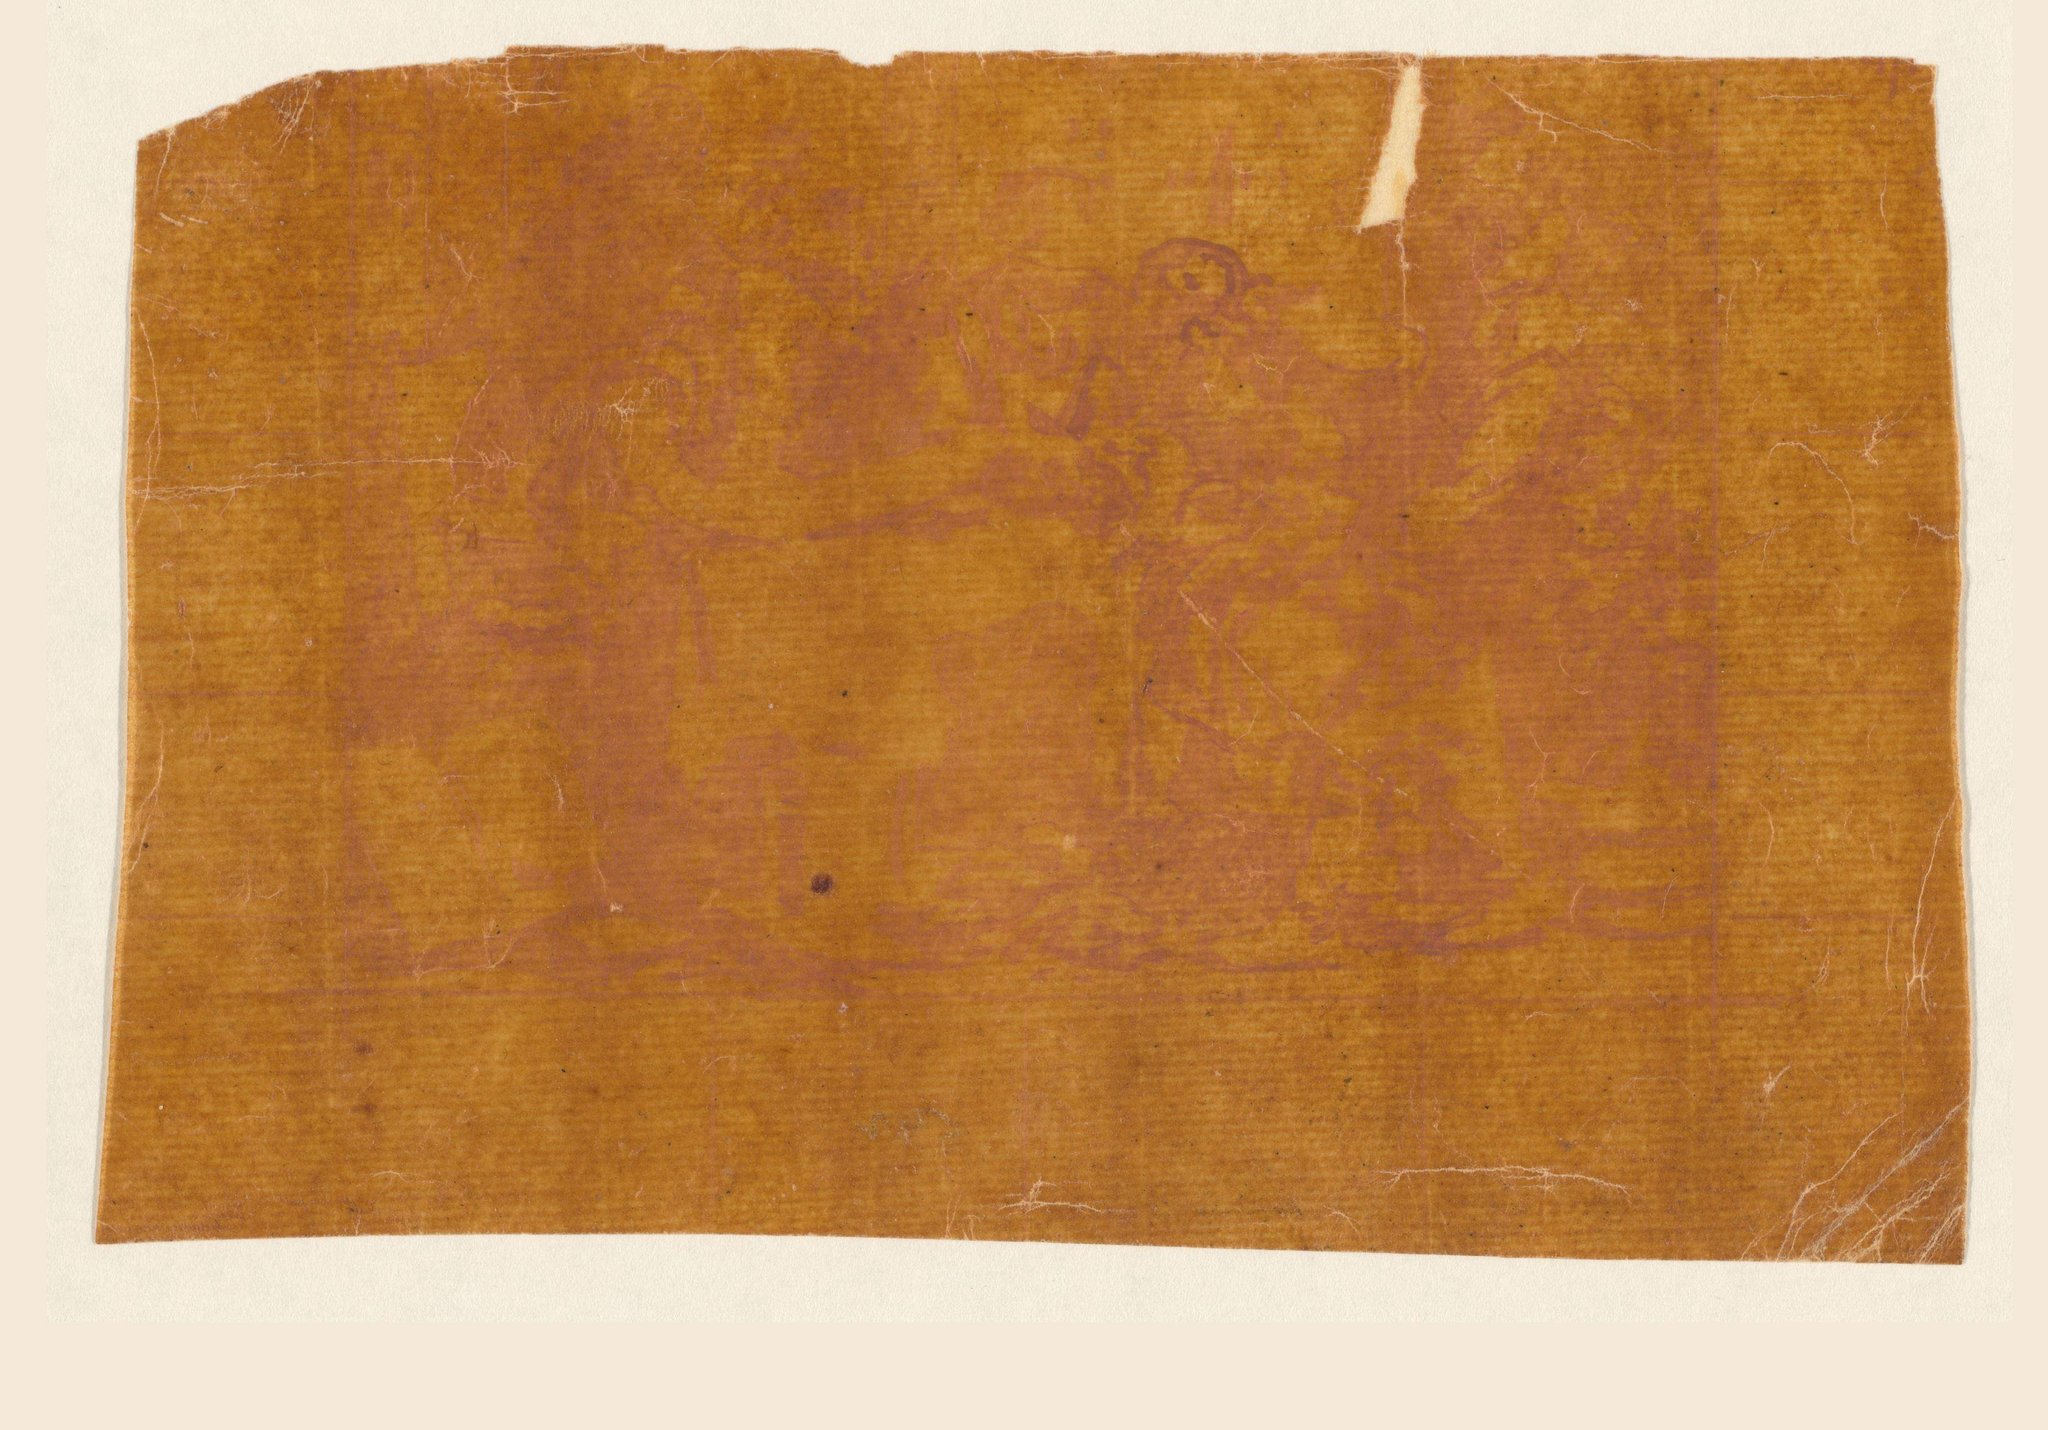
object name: drawing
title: Botanicus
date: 1780-1787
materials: chalk, paper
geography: amsterdam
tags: enjoying nature ~ plants, herbs and flowers, botany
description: Enkele mannen bestuderen planten aan een tafel. De oude zittende man schrijft in een boek. Een man draagt een mand met planten. Door de ramen zicht op een tuin en een landhuis. De doordruktekening ligt los in een album, zie blad 43.